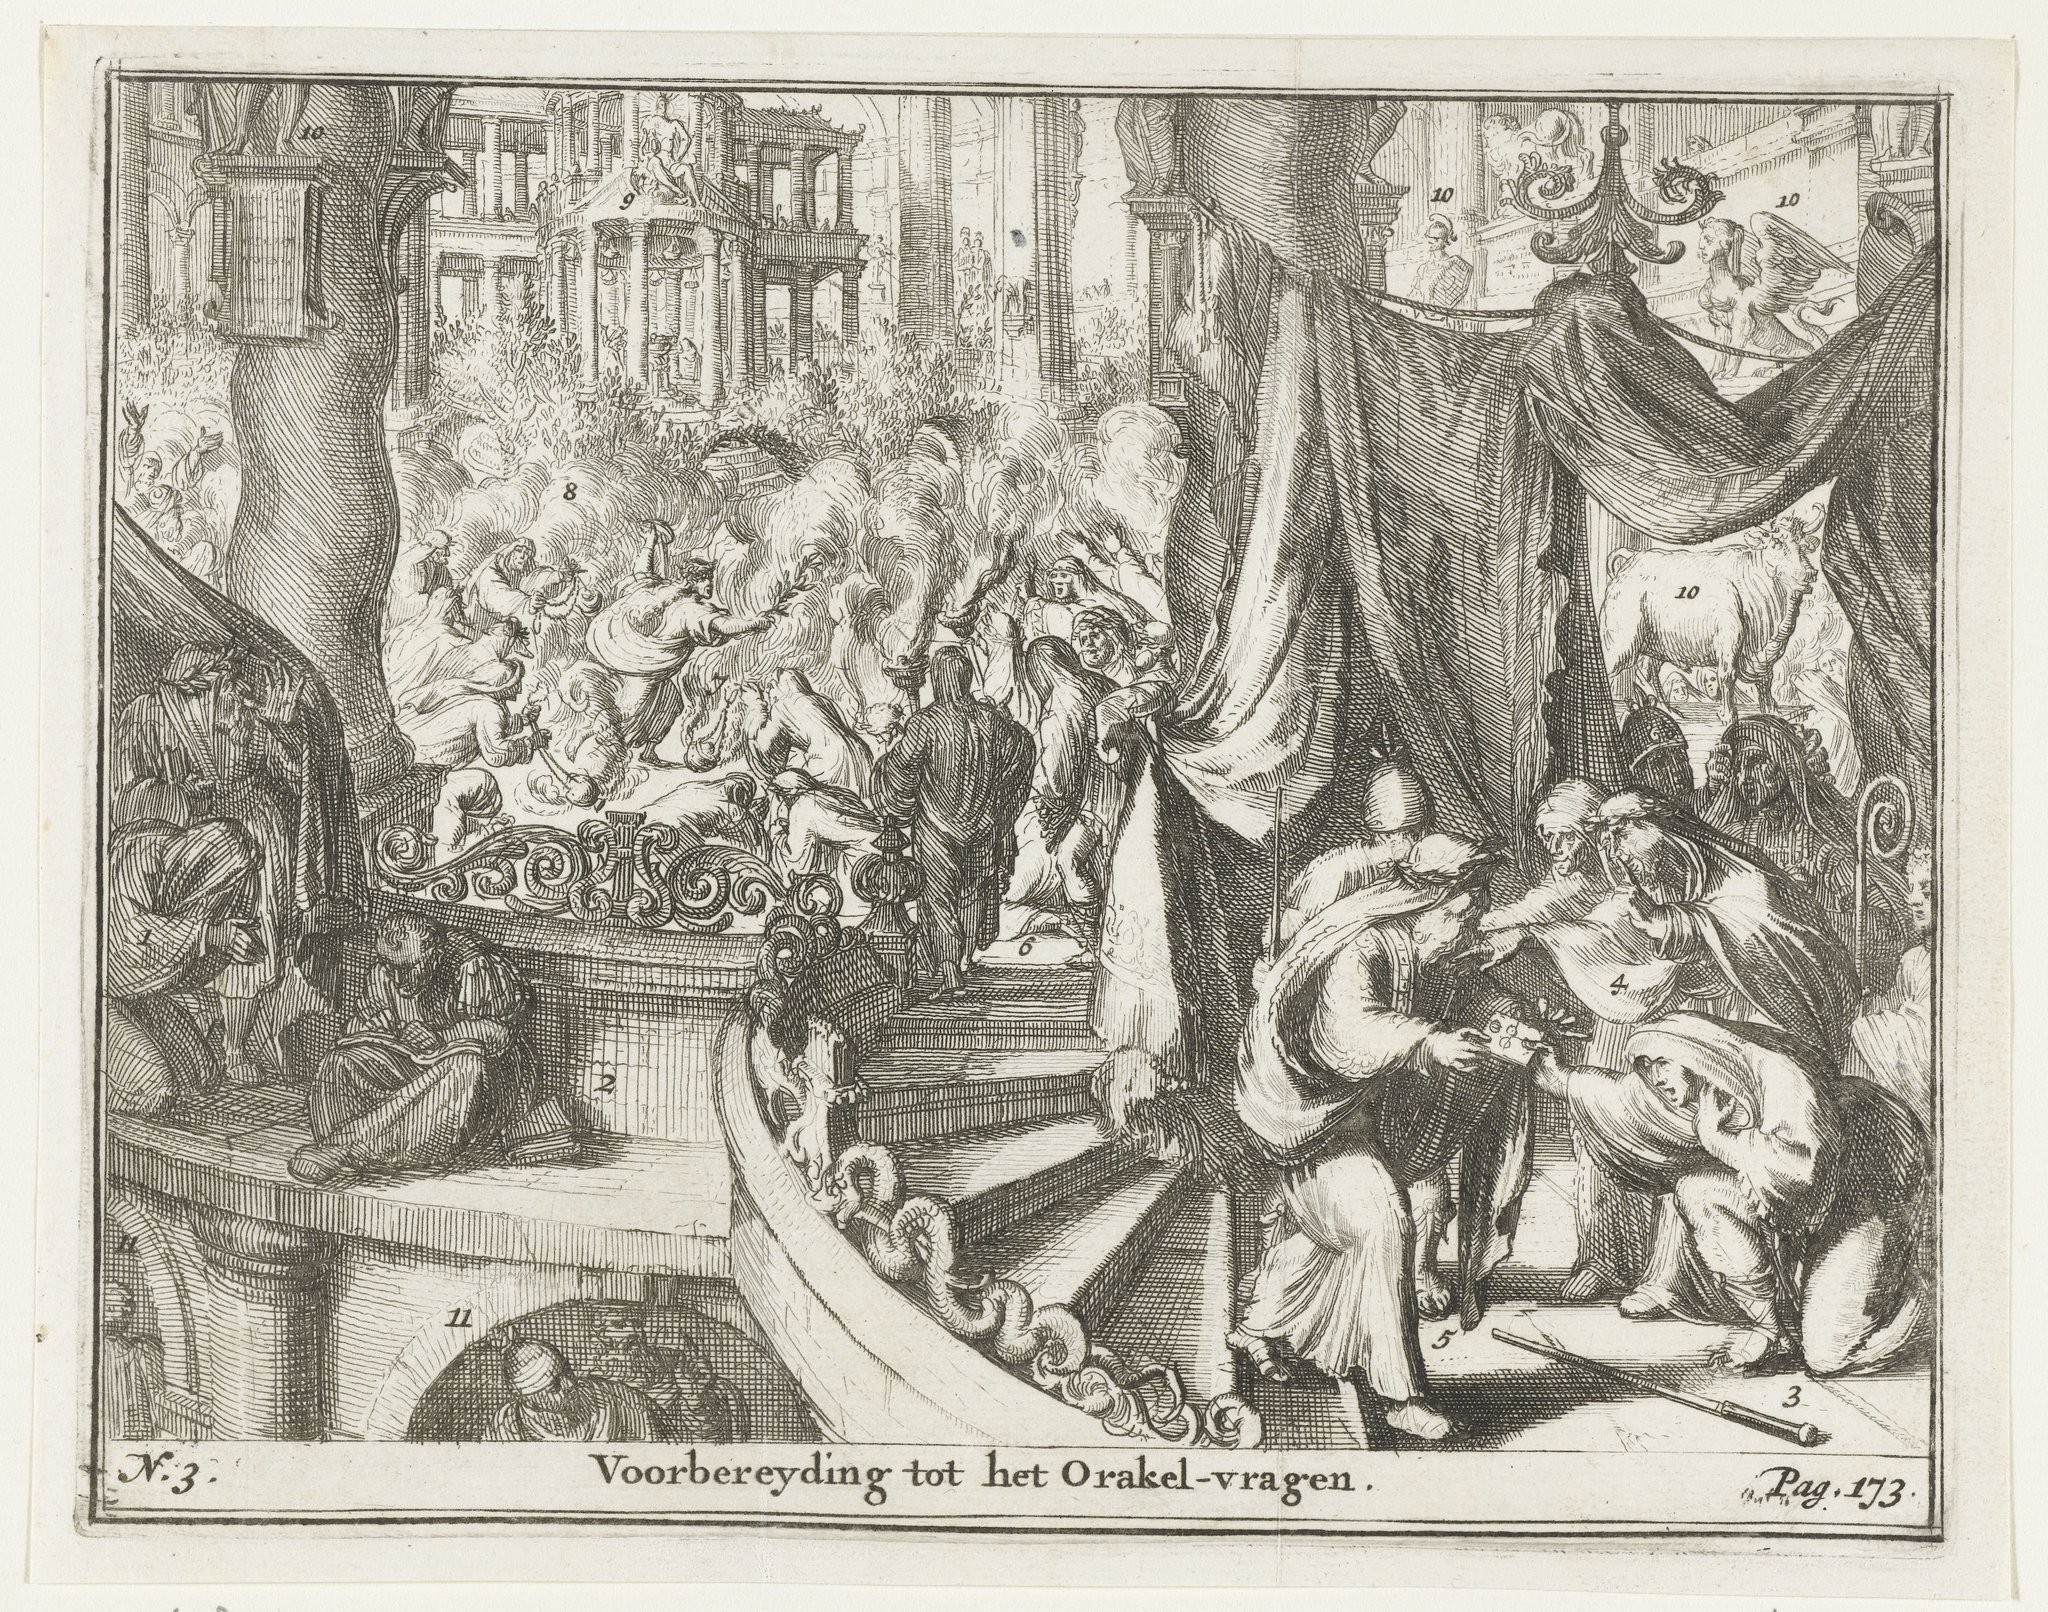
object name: print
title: Voorbereiding tot het raadplegen van het orakel van Delphi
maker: romeyn de hooghe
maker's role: draughtsman, goldsmith, painter, print maker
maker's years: 1645-1708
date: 1687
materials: paper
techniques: etching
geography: netherlands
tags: delphic oracle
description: Illustratie voor: Anthoni van Dale, Verhandeling van de oude orakelen der heydenen. De oraculis ethnicorum dissertationes duæ, Amsterdam 1687.